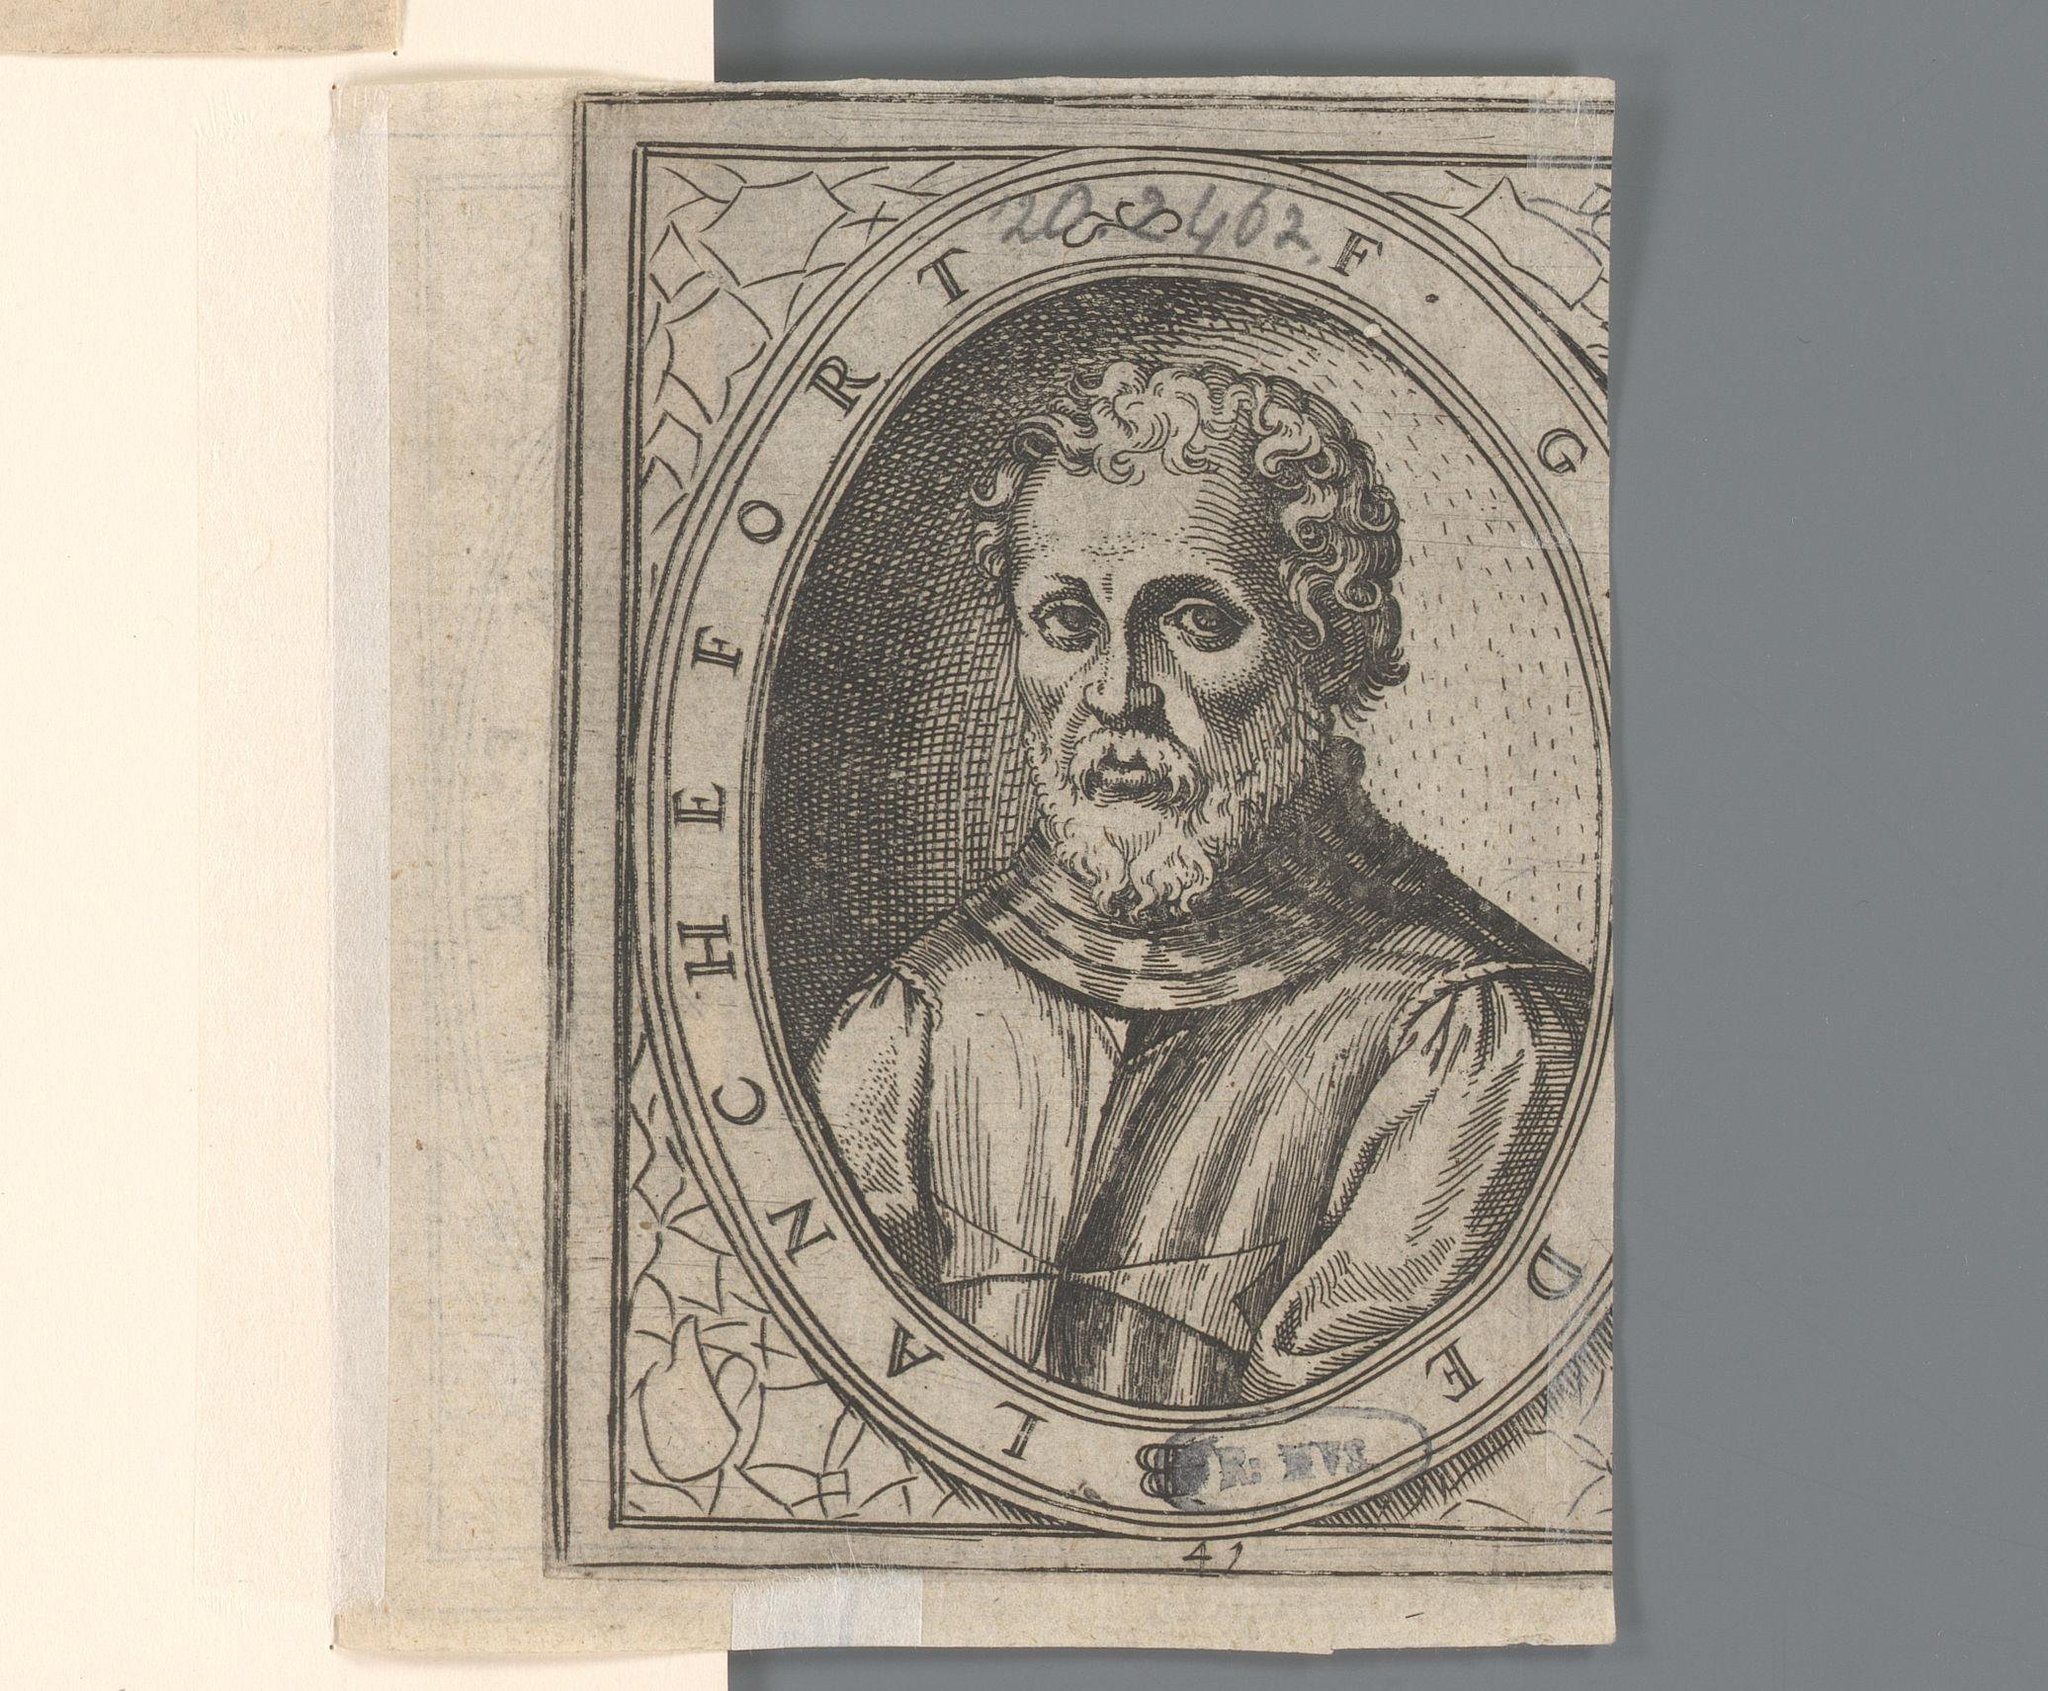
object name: print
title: Portret van Guy de Blanchefort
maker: Anonymous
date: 1643-1659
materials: paper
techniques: engraving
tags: historical persons, military orders, e.g.: knights templars, knights of malta, teutonic knights ~ roman catholic church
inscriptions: collector's mark: Lugt 2228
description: Prent mogelijk uit: Baudoin, Jean. Histoire des chevaliers de l'ordre de s. Jean de Hierusalem (...). Parijs: Jacques Dallin, 1643. Of uit: Baudoin, Jean. Histoire des chevaliers de l'ordre de s. Jean de Hierusalem (...). Parijs: Thomas Jolly, 1659.